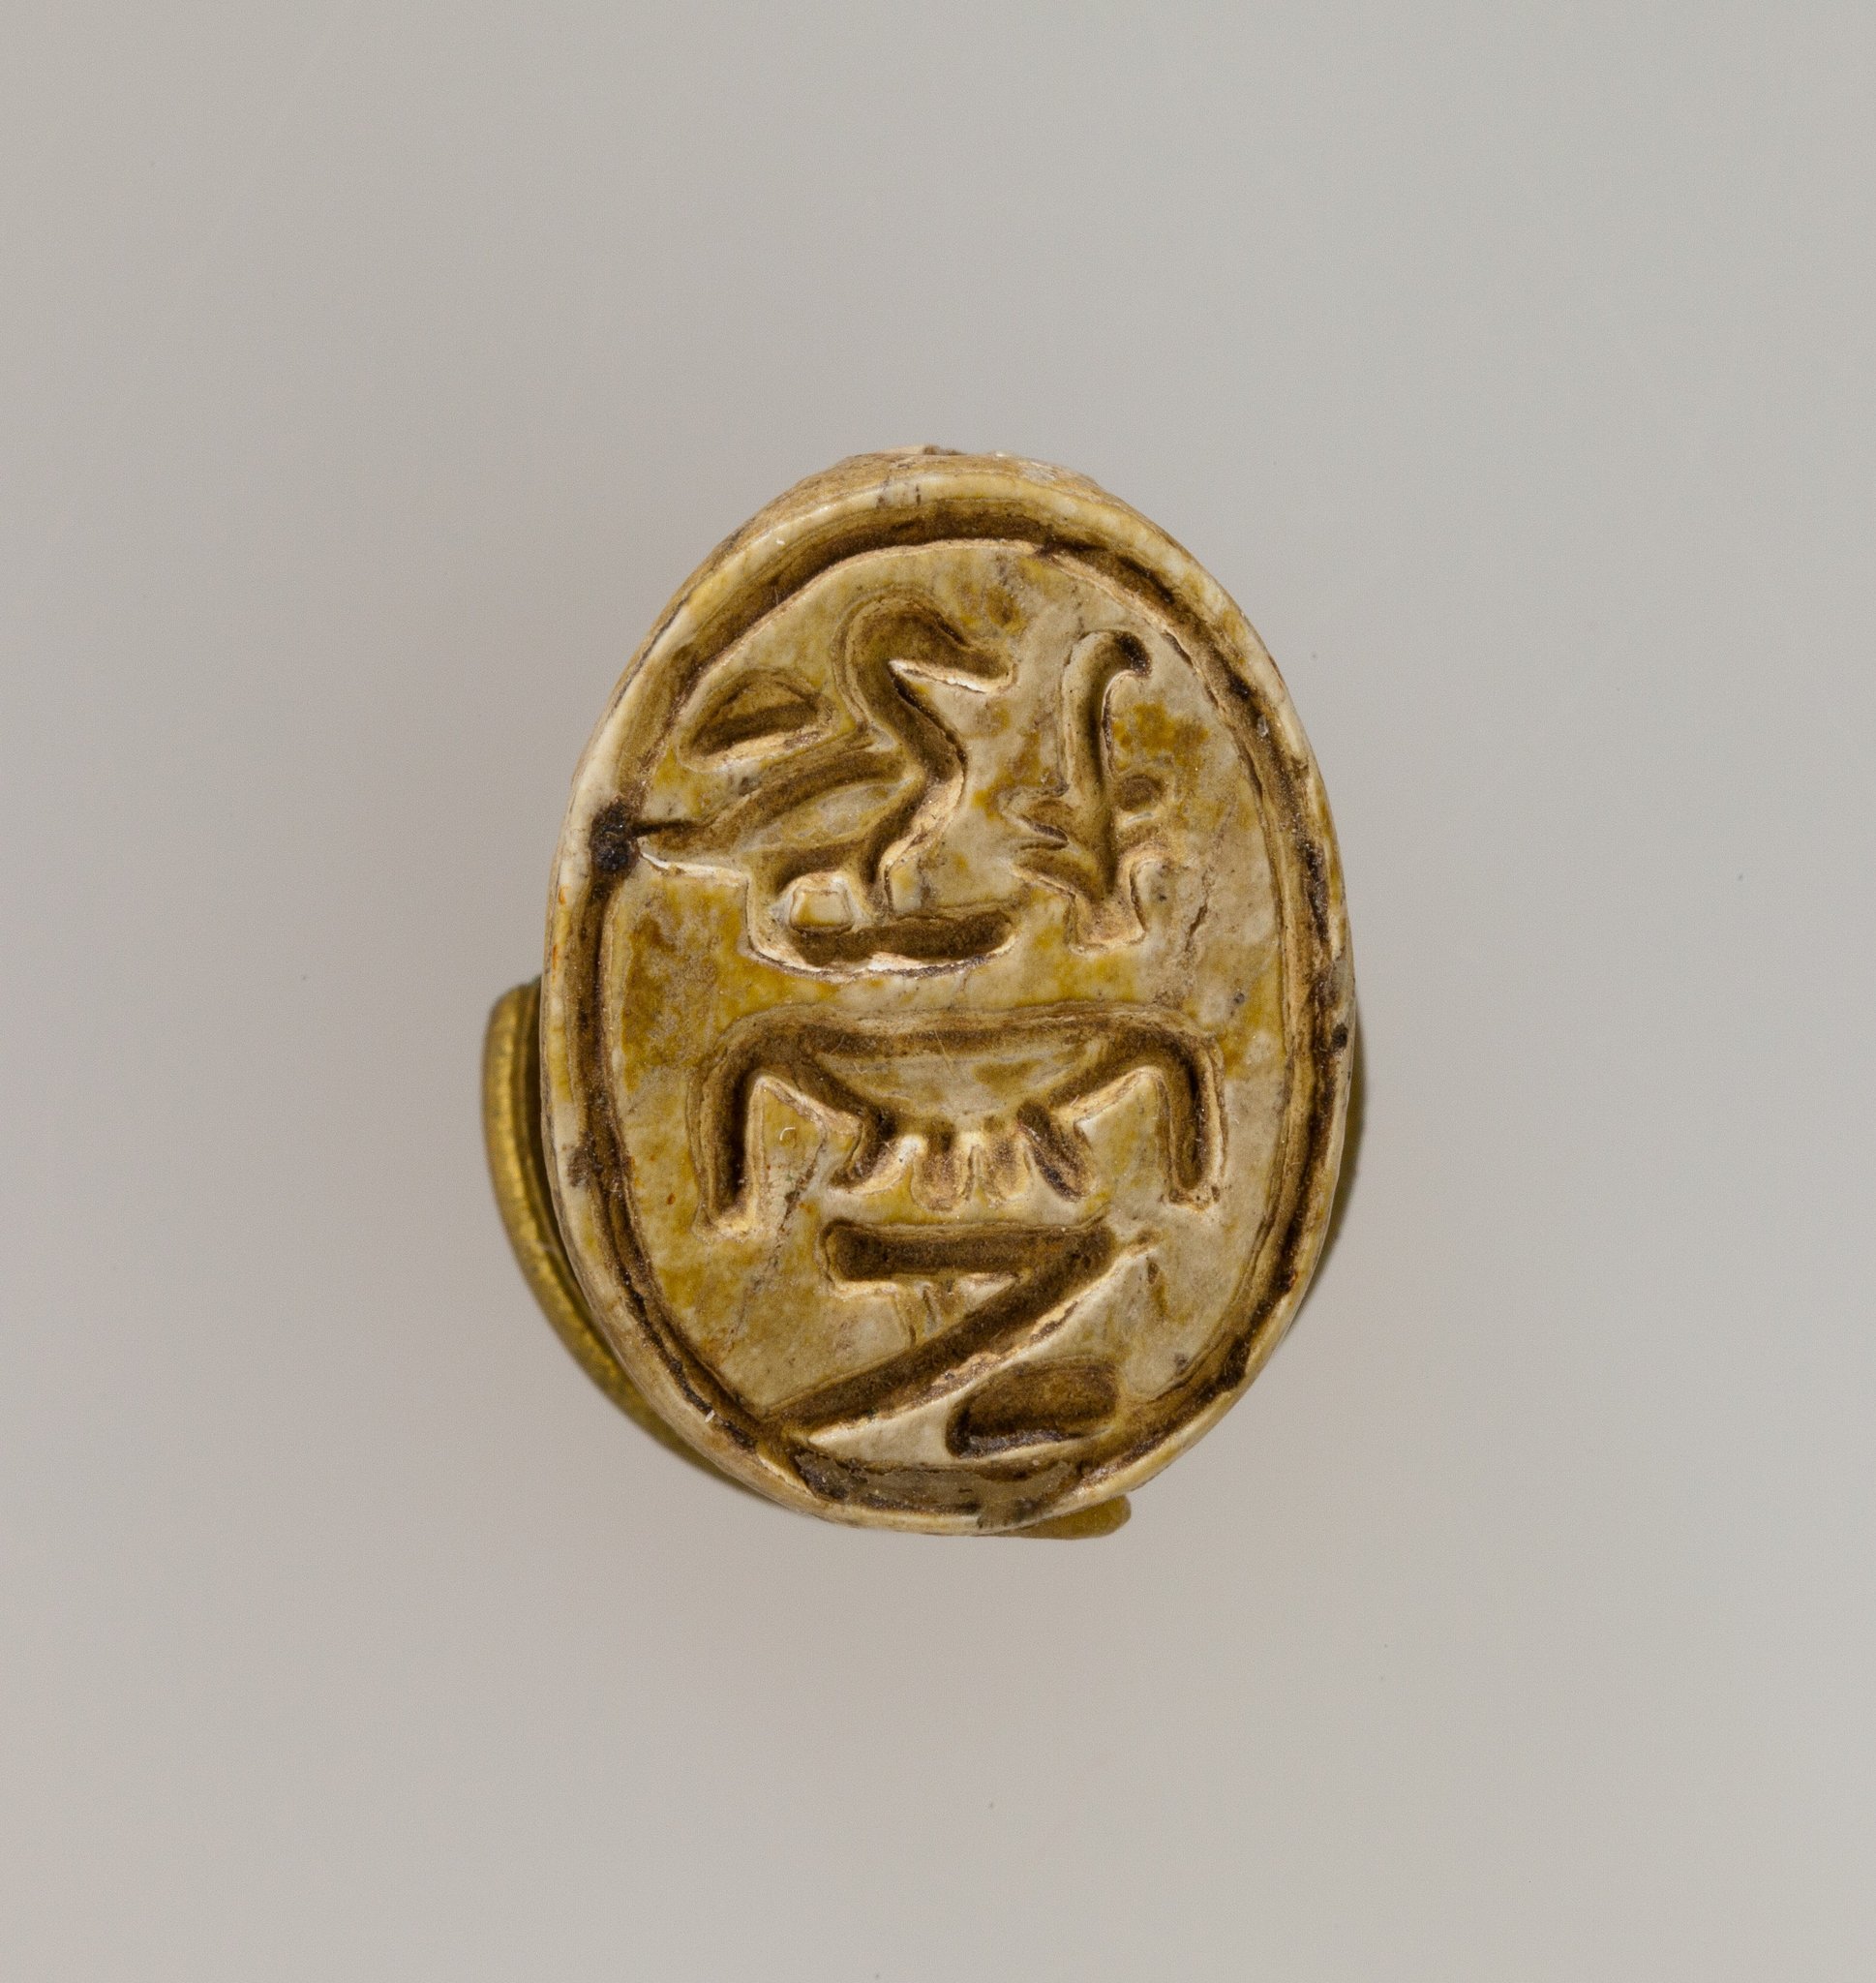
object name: scarab, princess merytnub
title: Scarab Inscribed for Princess Merytnub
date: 1550-1295 BCE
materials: stone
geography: egypt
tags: scarabs